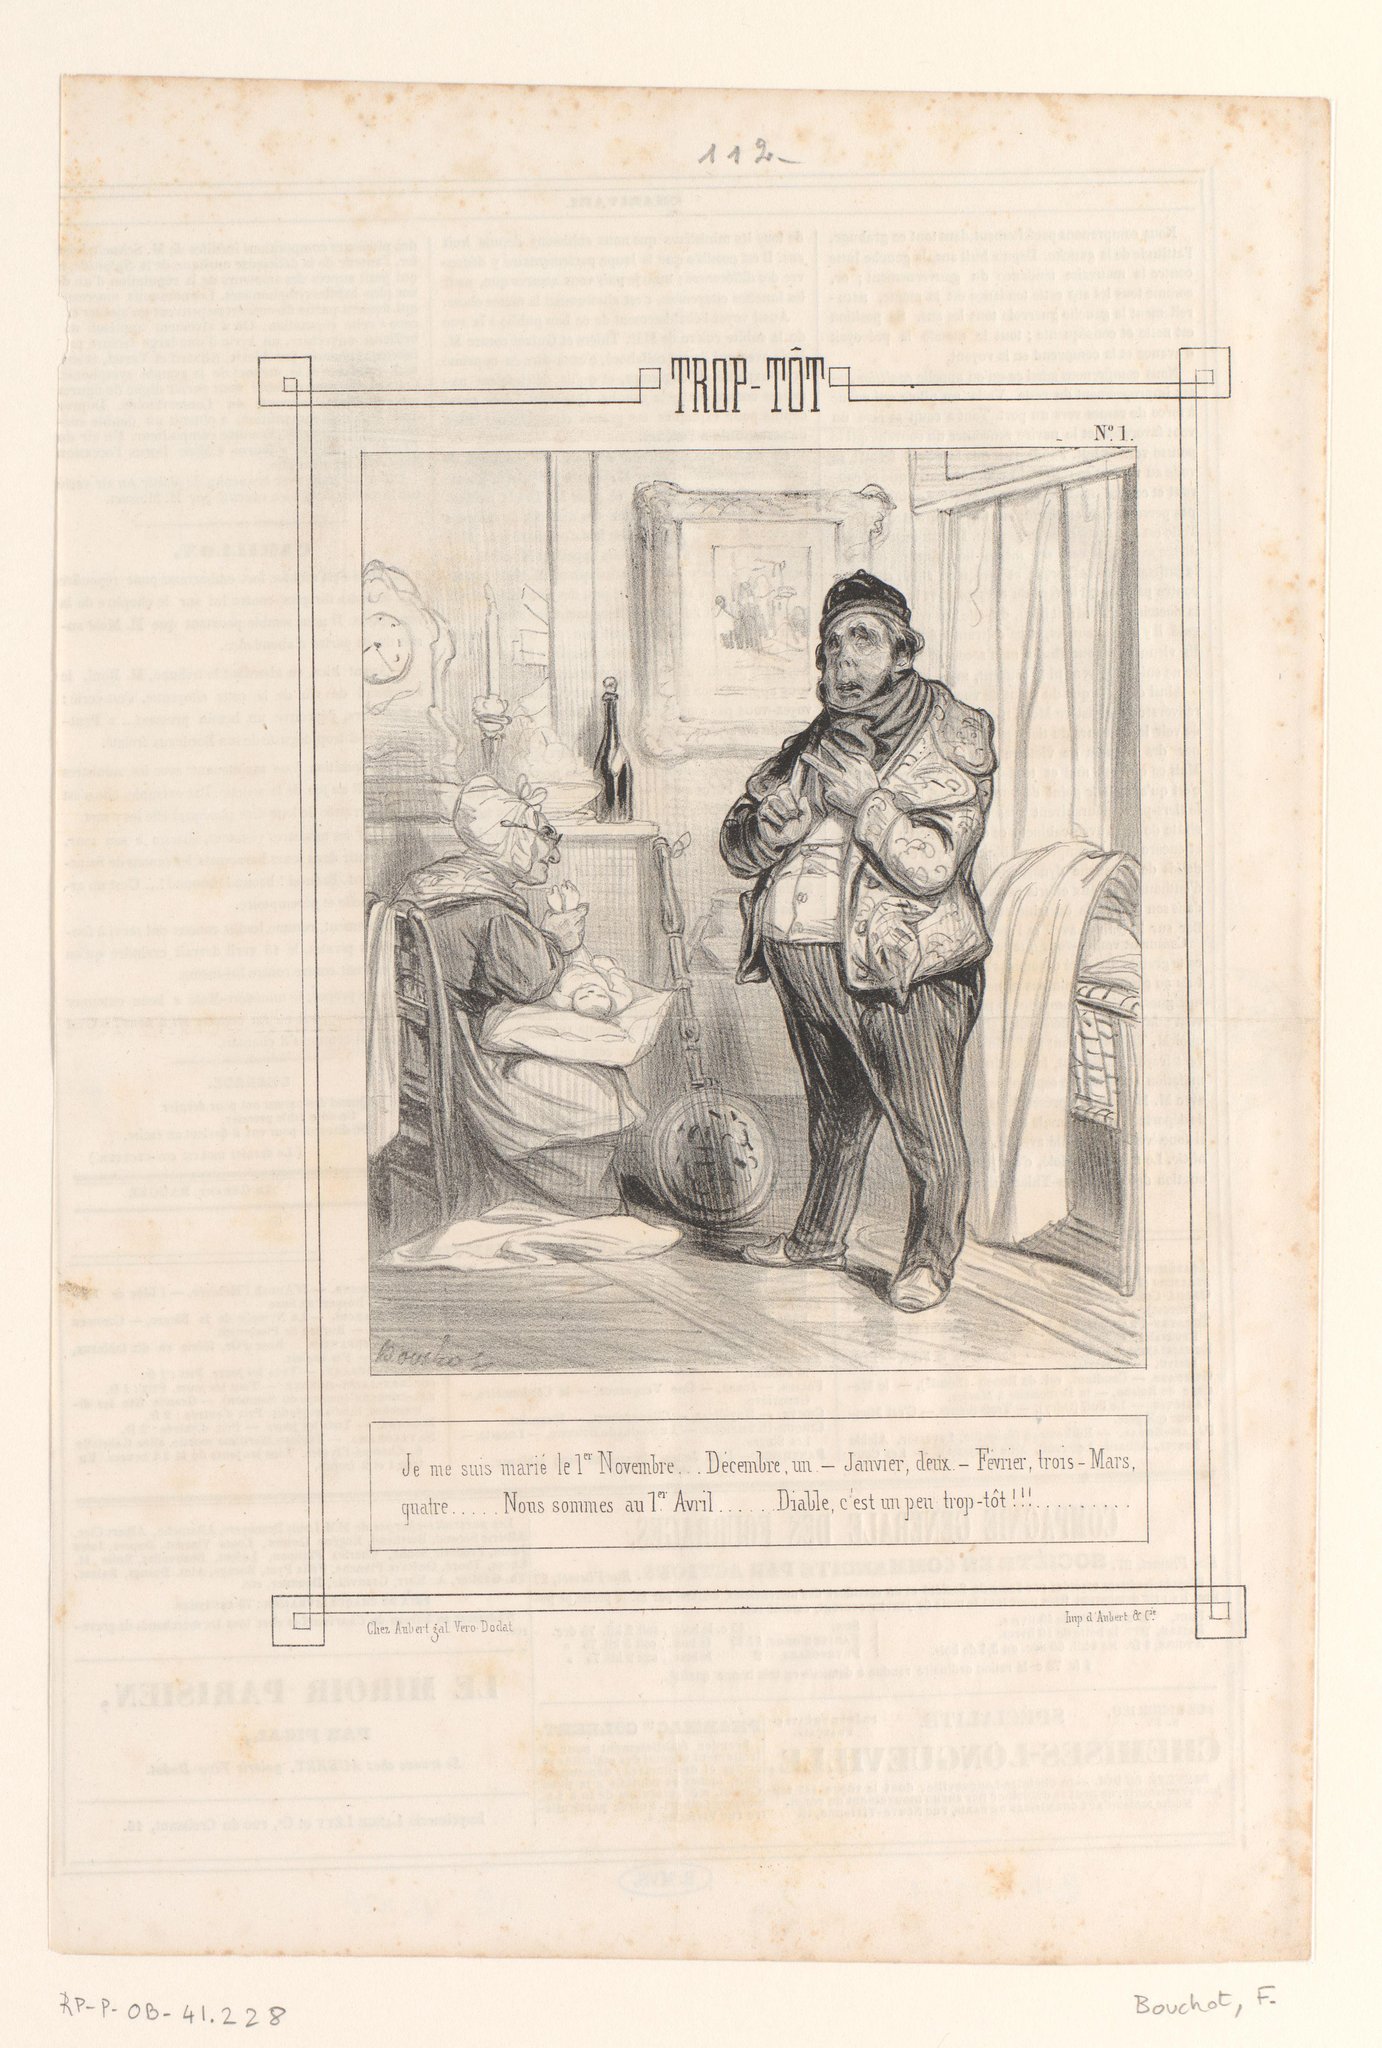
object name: cartoon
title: Je me suis marié le 1er Novembre (...)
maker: frédéric bouchot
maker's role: draughtsman, print maker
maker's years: 1798-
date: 1838-1840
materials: paper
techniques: lithograph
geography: paris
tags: partner deceived, the new-born child, taking care of children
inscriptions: stamp: ‘Timbre Royal 3c. Seine’, number: ‘112’, collector's mark: Lugt 2228a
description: Een man telt op zijn vingers vijf maanden vanaf zijn trouwdatum. Hij realiseert zich dat de pasgeboren baby, die op de achtergrond wordt verschoond, dus niet van hem kan zijn. Het is nog te vroeg voor een voldragen baby.